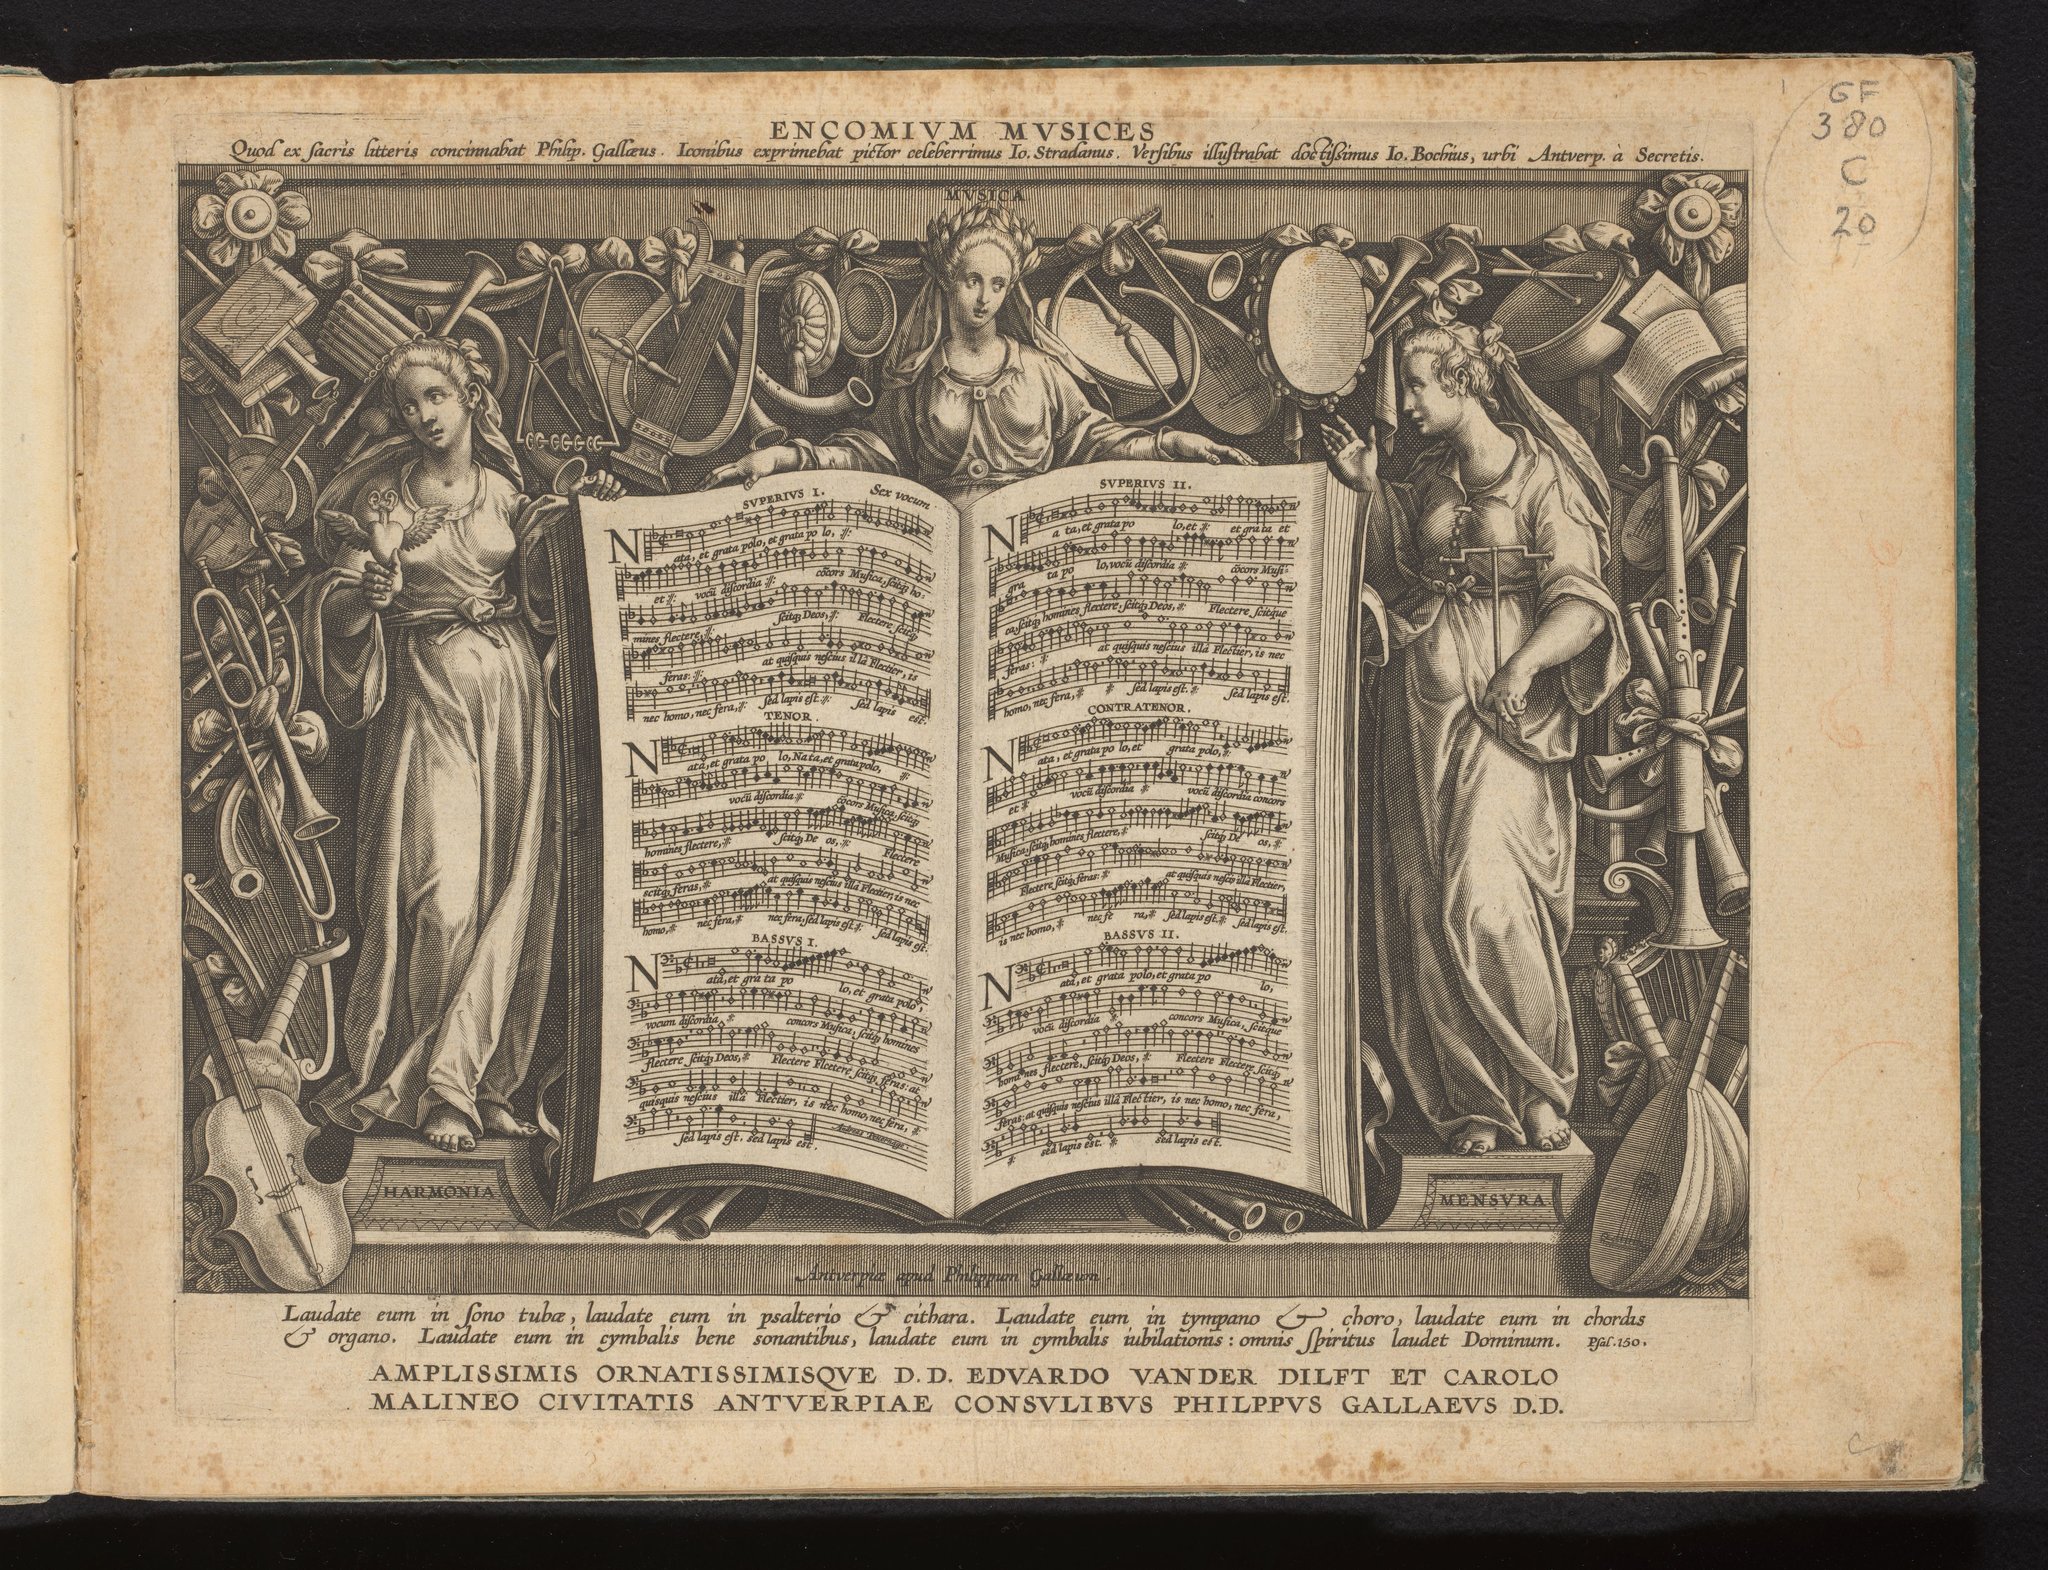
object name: titelprent, frontispice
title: Encomium musices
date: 1587-1592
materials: paper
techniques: engraving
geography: antwerp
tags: musical instruments; group of musical instruments, 'musica', symbolic representations, allegories and emblems ~ music; 'musica'(ripa), harmony, regularity, title-page, printed edition of musical score, harmonious sound, harmony, consonance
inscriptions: collector's mark: Lugt 2166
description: Allegorie op de lof der muziek. Titelprent voor de serie getiteld: Encomium Mucies. In het midden een open boek met de muzieknotatie van het zesstemmig motet: Nata, et grata polo, et vocum discordia concors Musica, scitque homines flectere, scitque Deos. Flectere scitque feras: at quisquis nescius illa flectier, is nec homo, nec fera, sed lapis est (De muziek is in de hemel geboren en behaagt God met haar meerstemmigheid die in harmonie klinkt. Zij kan zowel stervelingen als goden beroeren, en zij kan zelfs wilde dieren raken. Degene die niet door muziek wordt geroerd, is geen mens of dier, maar een steen). Het muziekboek wordt vastgehouden door drie vrouwenfiguren: Harmonia, Musica en Mensura. Musica (in het midden) draagt een lauwerkrans op het hoofd. Harmonia (links) heeft een gevleugeld hart, voorzien van oren, in de rechterhand. Mensura heeft een T-vormig instrument met klokjes in de linkerhand (de voorloper van de metronoom?). De drie personificaties zijn omgeven door muziekinstrumenten en muziekboeken die samen een ornamentale rand om het muziekboek vormen. Het zijn zowel contemporaine instrumenten, reconstructies van oude instrumenten, als eigen inventies. De prent maakt deel uit van een album.